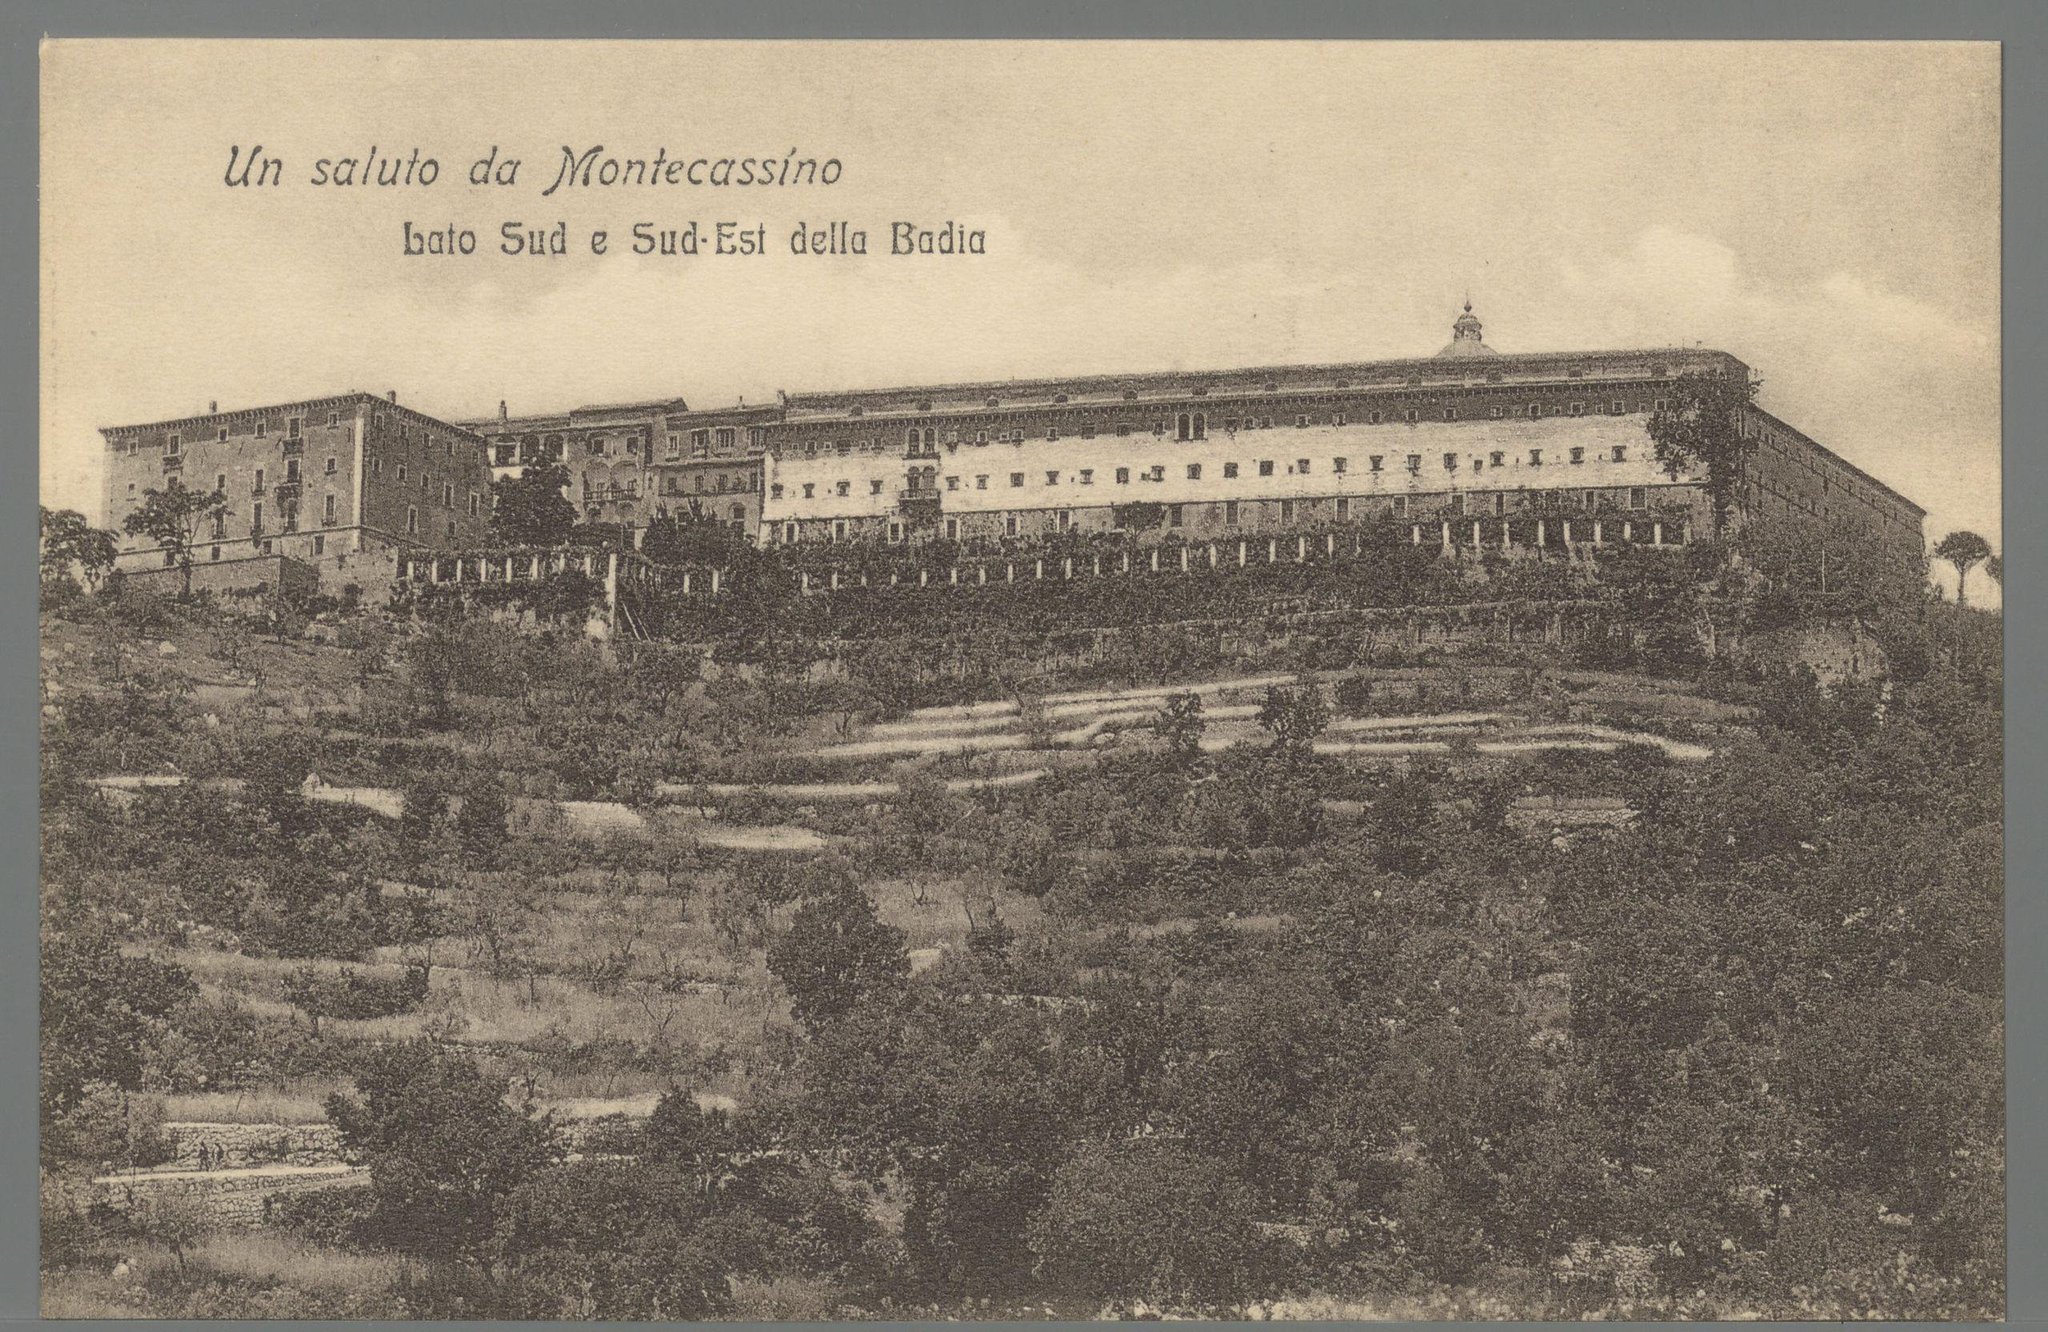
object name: photomechanical print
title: Lato Sud e Sud-Est della Badia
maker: Anonymous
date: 1906-1910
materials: cardboard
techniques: photograph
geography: terni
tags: abbey, monastery, convent ~ roman catholic church, exterior ~ representation of a building